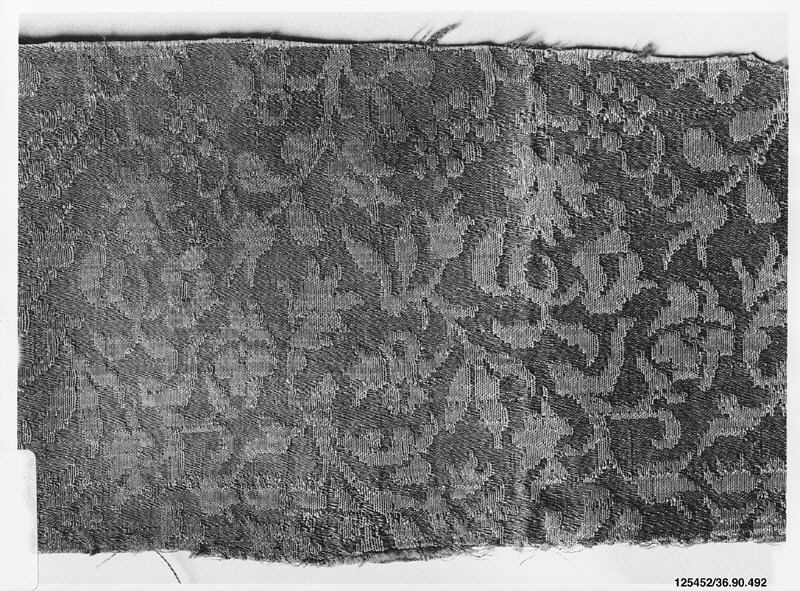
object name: piece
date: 1501-1700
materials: silk